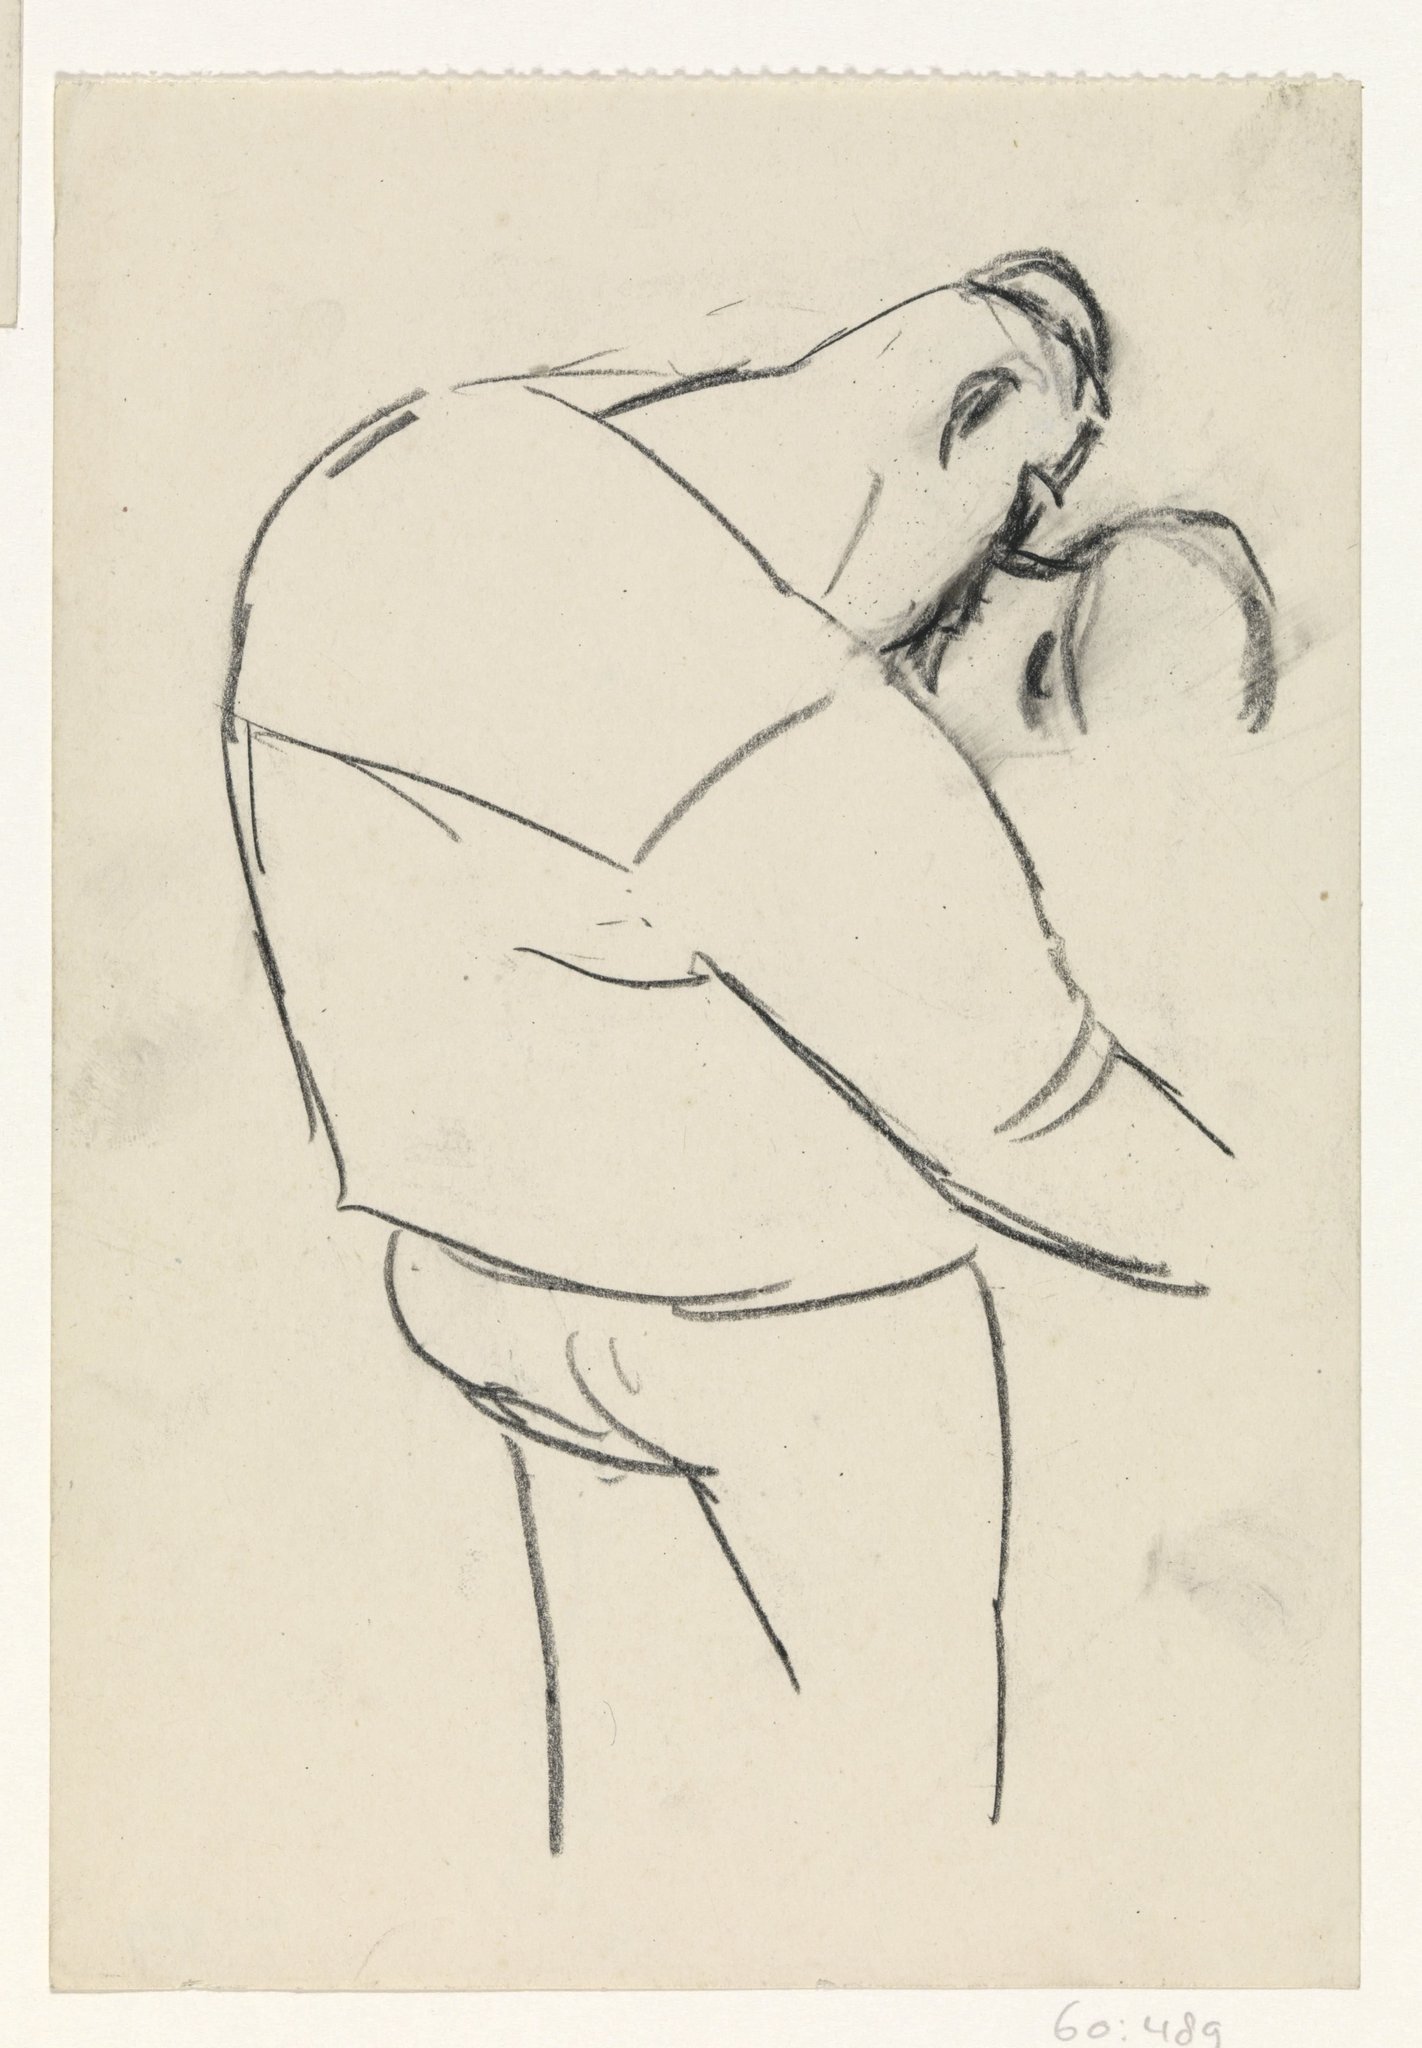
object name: drawing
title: Kussend stel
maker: leo gestel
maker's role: draughtsman, print maker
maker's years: 1881-1941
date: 1891-1941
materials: chalk, paper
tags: (lovers) kissing each other, embracing each other, kissing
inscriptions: collector's mark: Lugt 2228